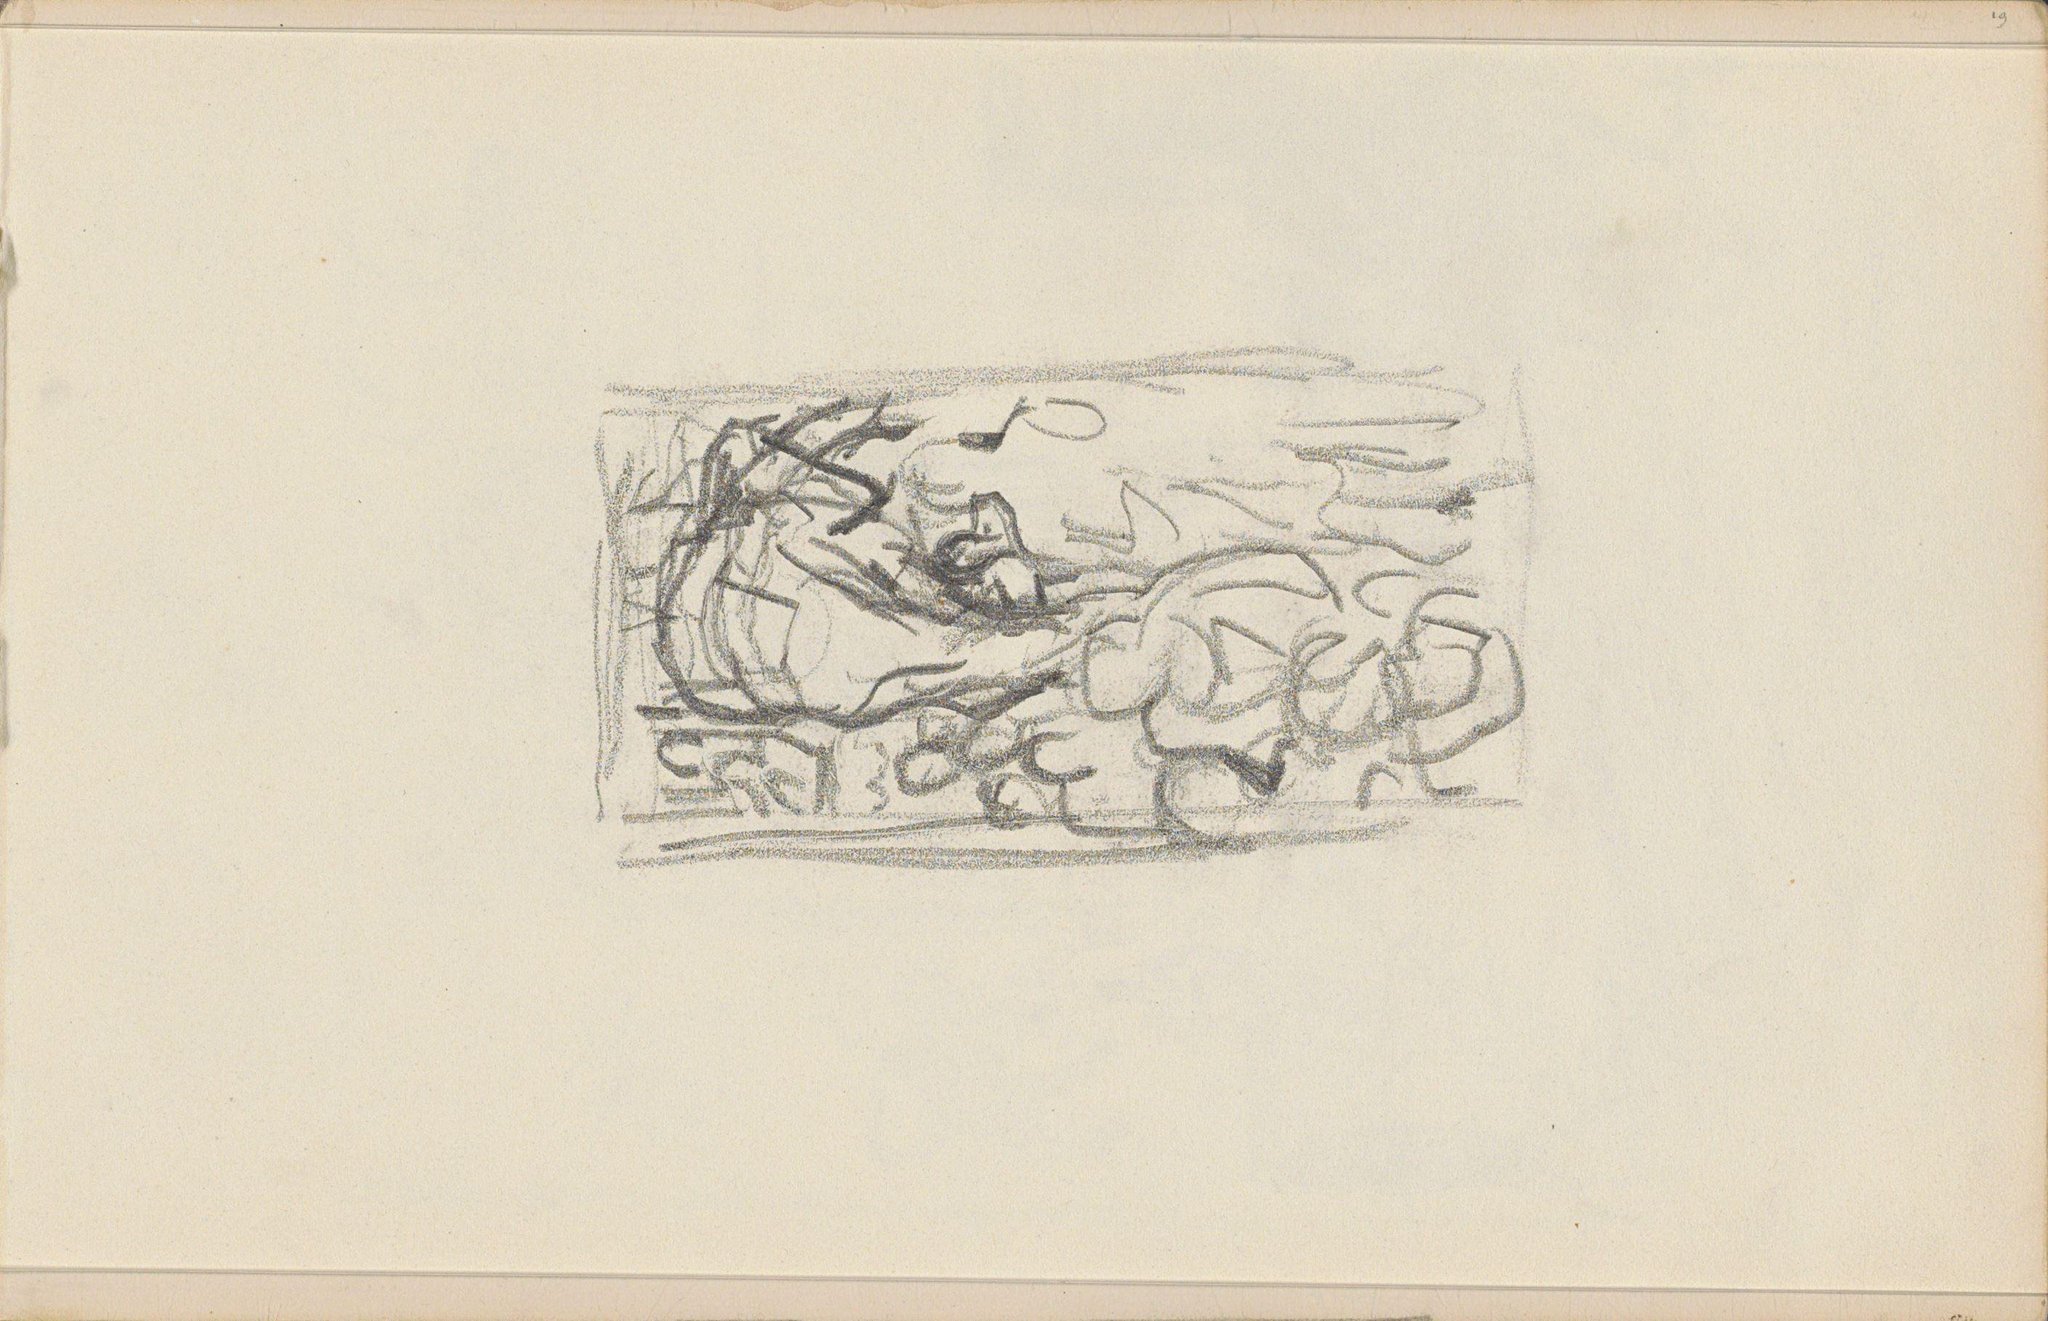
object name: sketchbook leaf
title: Figuren naast een olifant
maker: marius bauer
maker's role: draughtsman, print maker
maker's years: 1867-1932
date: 1924-1925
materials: paper, pencil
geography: india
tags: asiatic races and peoples: indians, trunked animals: elephant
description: Pagina 19 uit een schetsboek met 48 bladen.